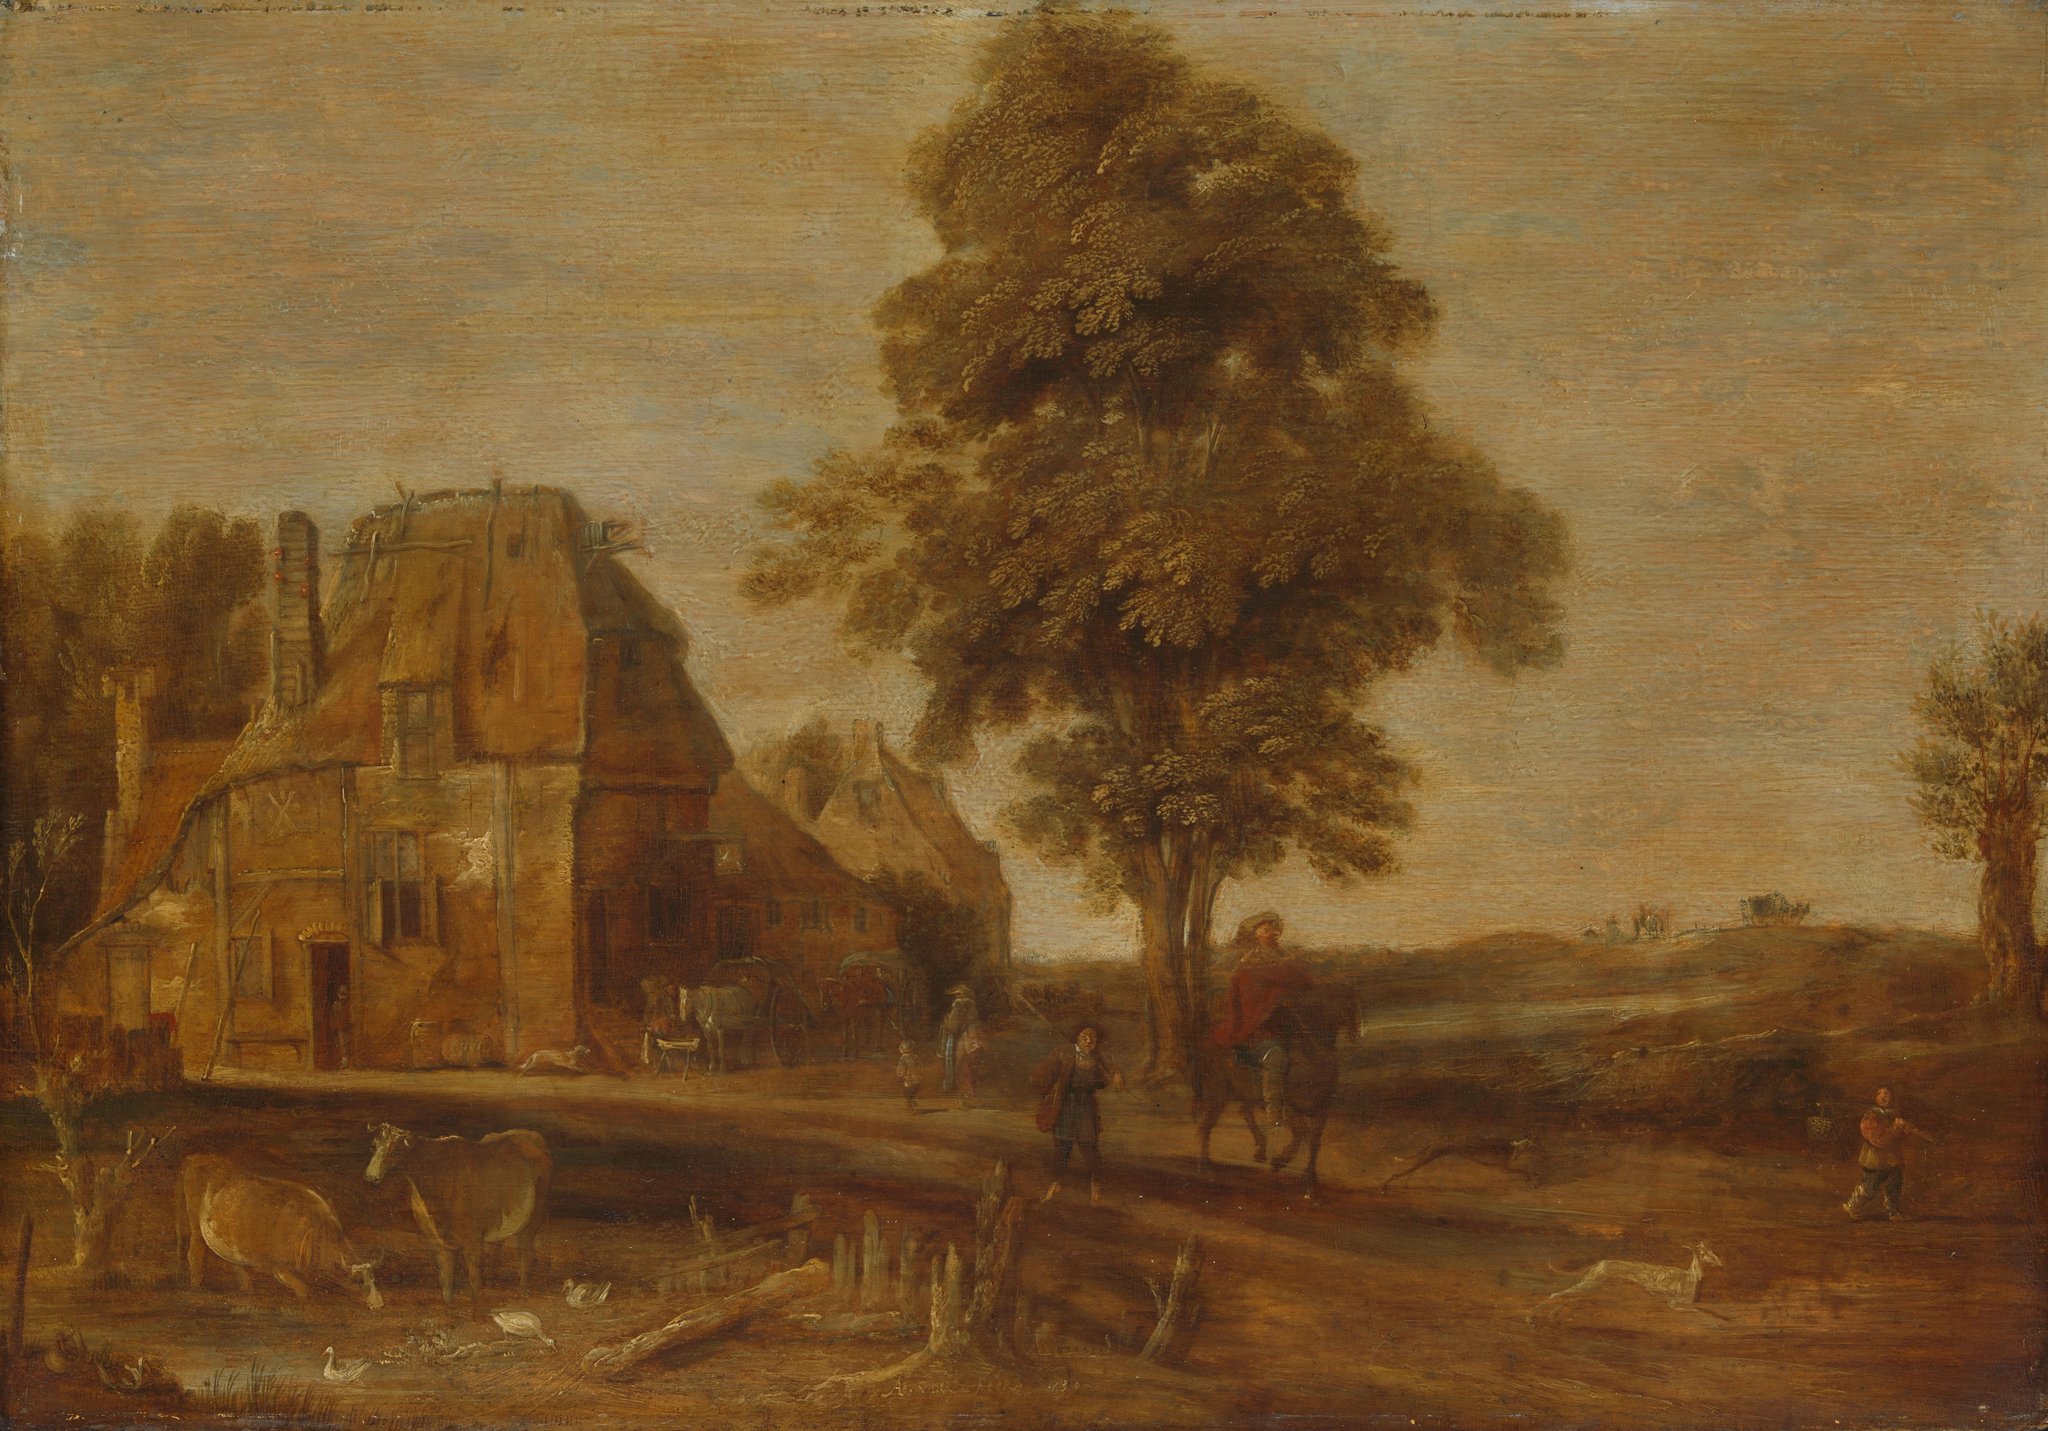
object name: painting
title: Landscape with an Inn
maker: aert van der neer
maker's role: painter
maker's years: 1603-1677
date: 1639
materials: oil, panel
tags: inn, coffee-house, public house, etc., farm or solitary house in landscape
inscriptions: signature and date, bottom centre: ‘A . v DeR NeeR 1639’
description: Landschap met pleisterplaats. Links een herberg in een heuvelachtig landschap met een grote boom waar paarden met wagens rusten. Linksvoor enkele koeien en eenden, op de weg een ruiter en een man te voet.